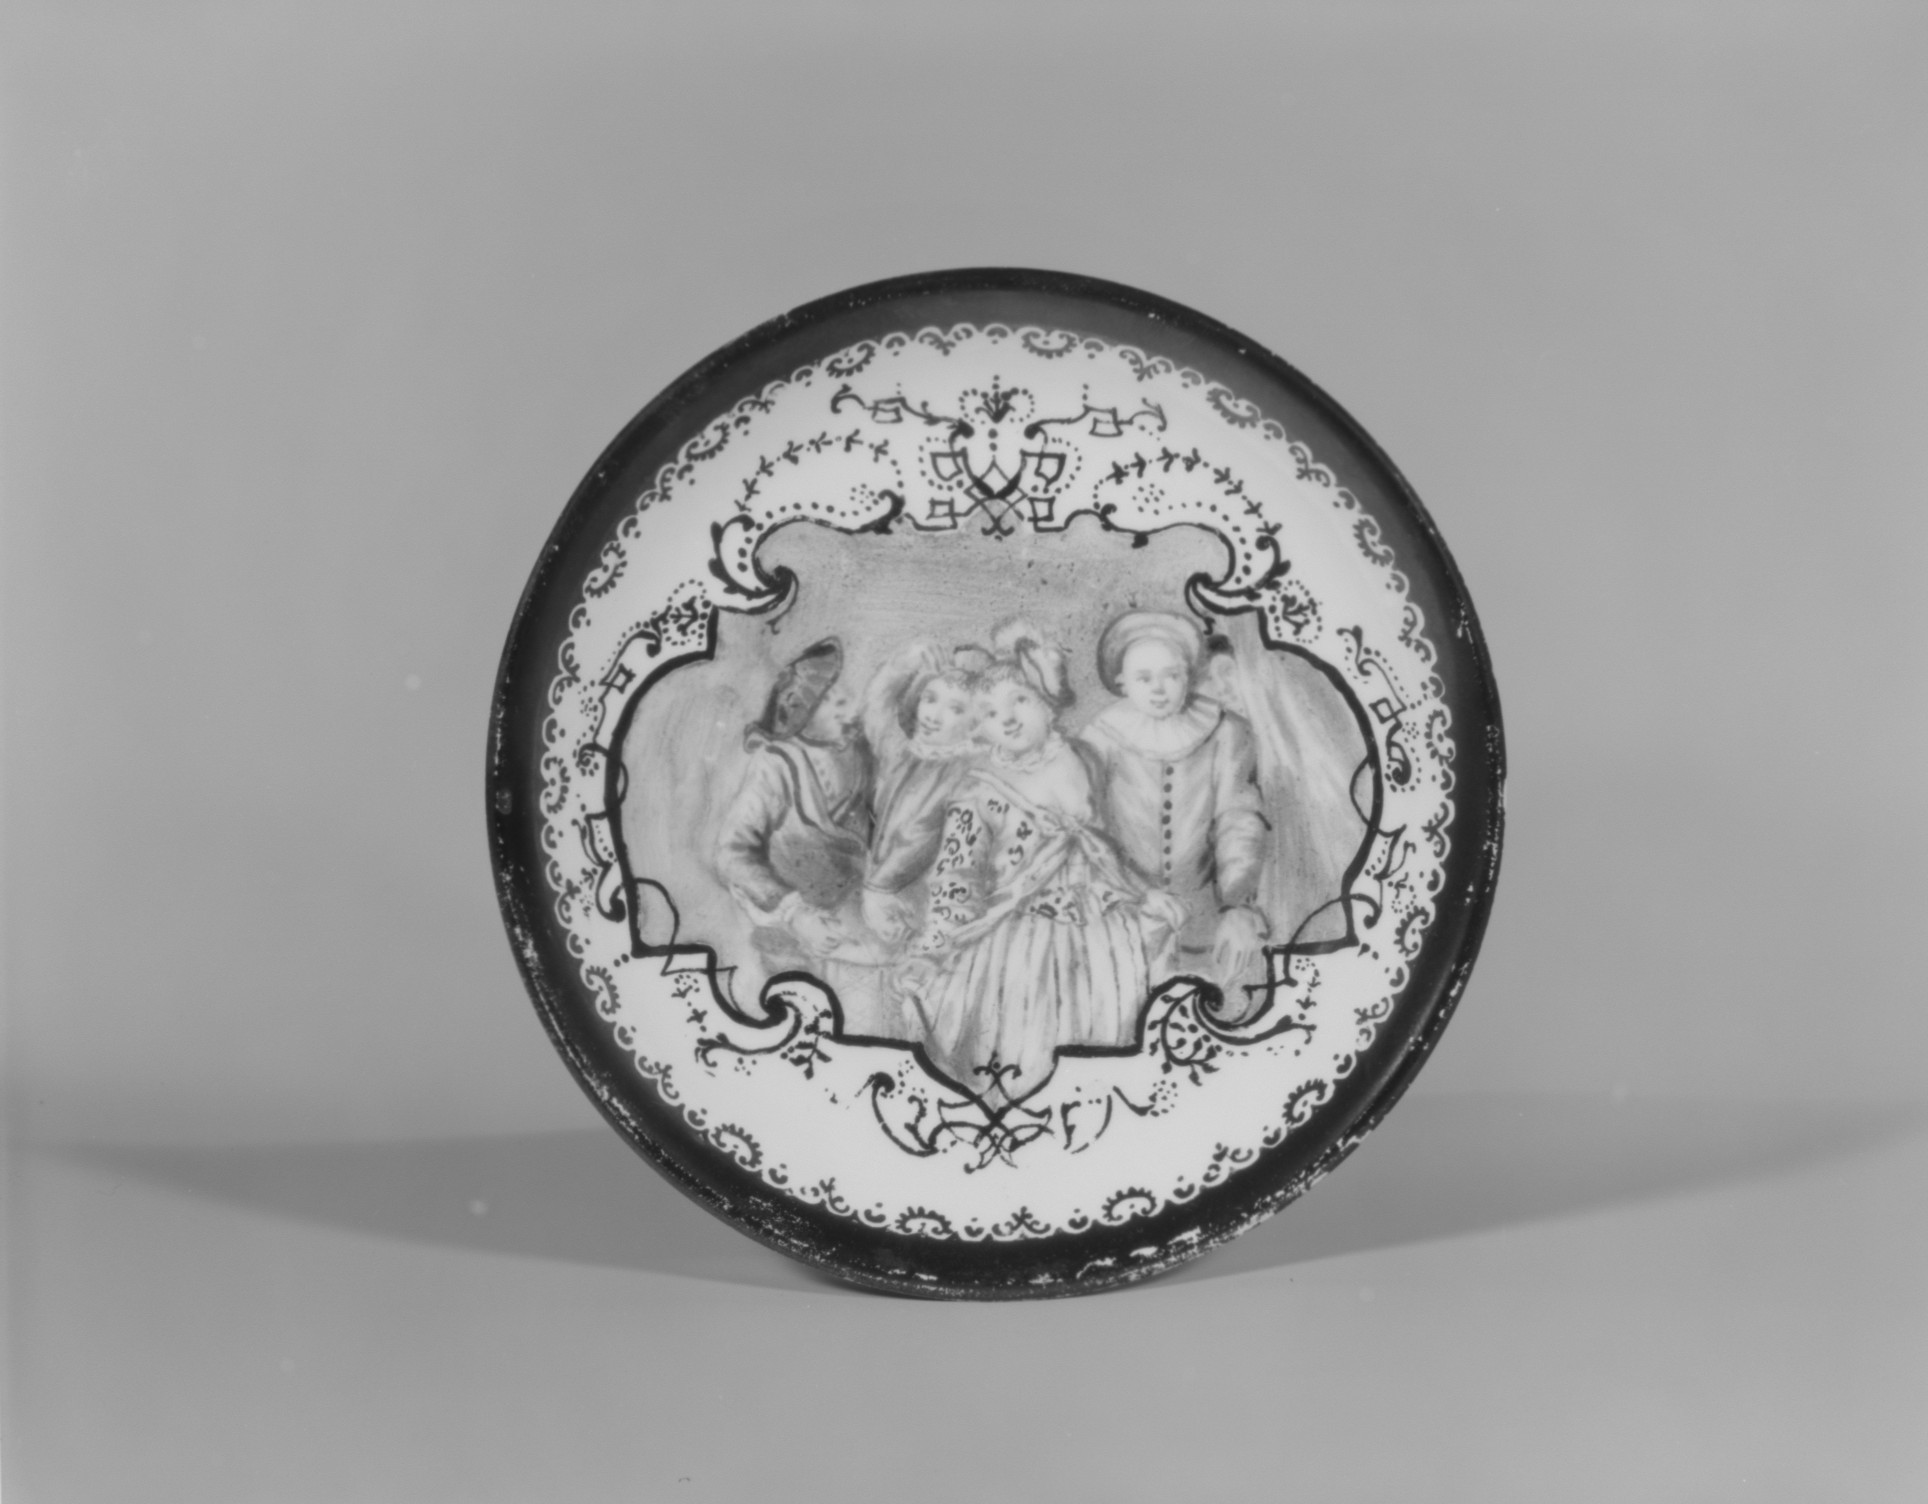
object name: saucer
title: Saucer (part of a service)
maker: meissen manufactory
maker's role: manufactory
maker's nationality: german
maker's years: 1710-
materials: hard paste porcelain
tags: human figures